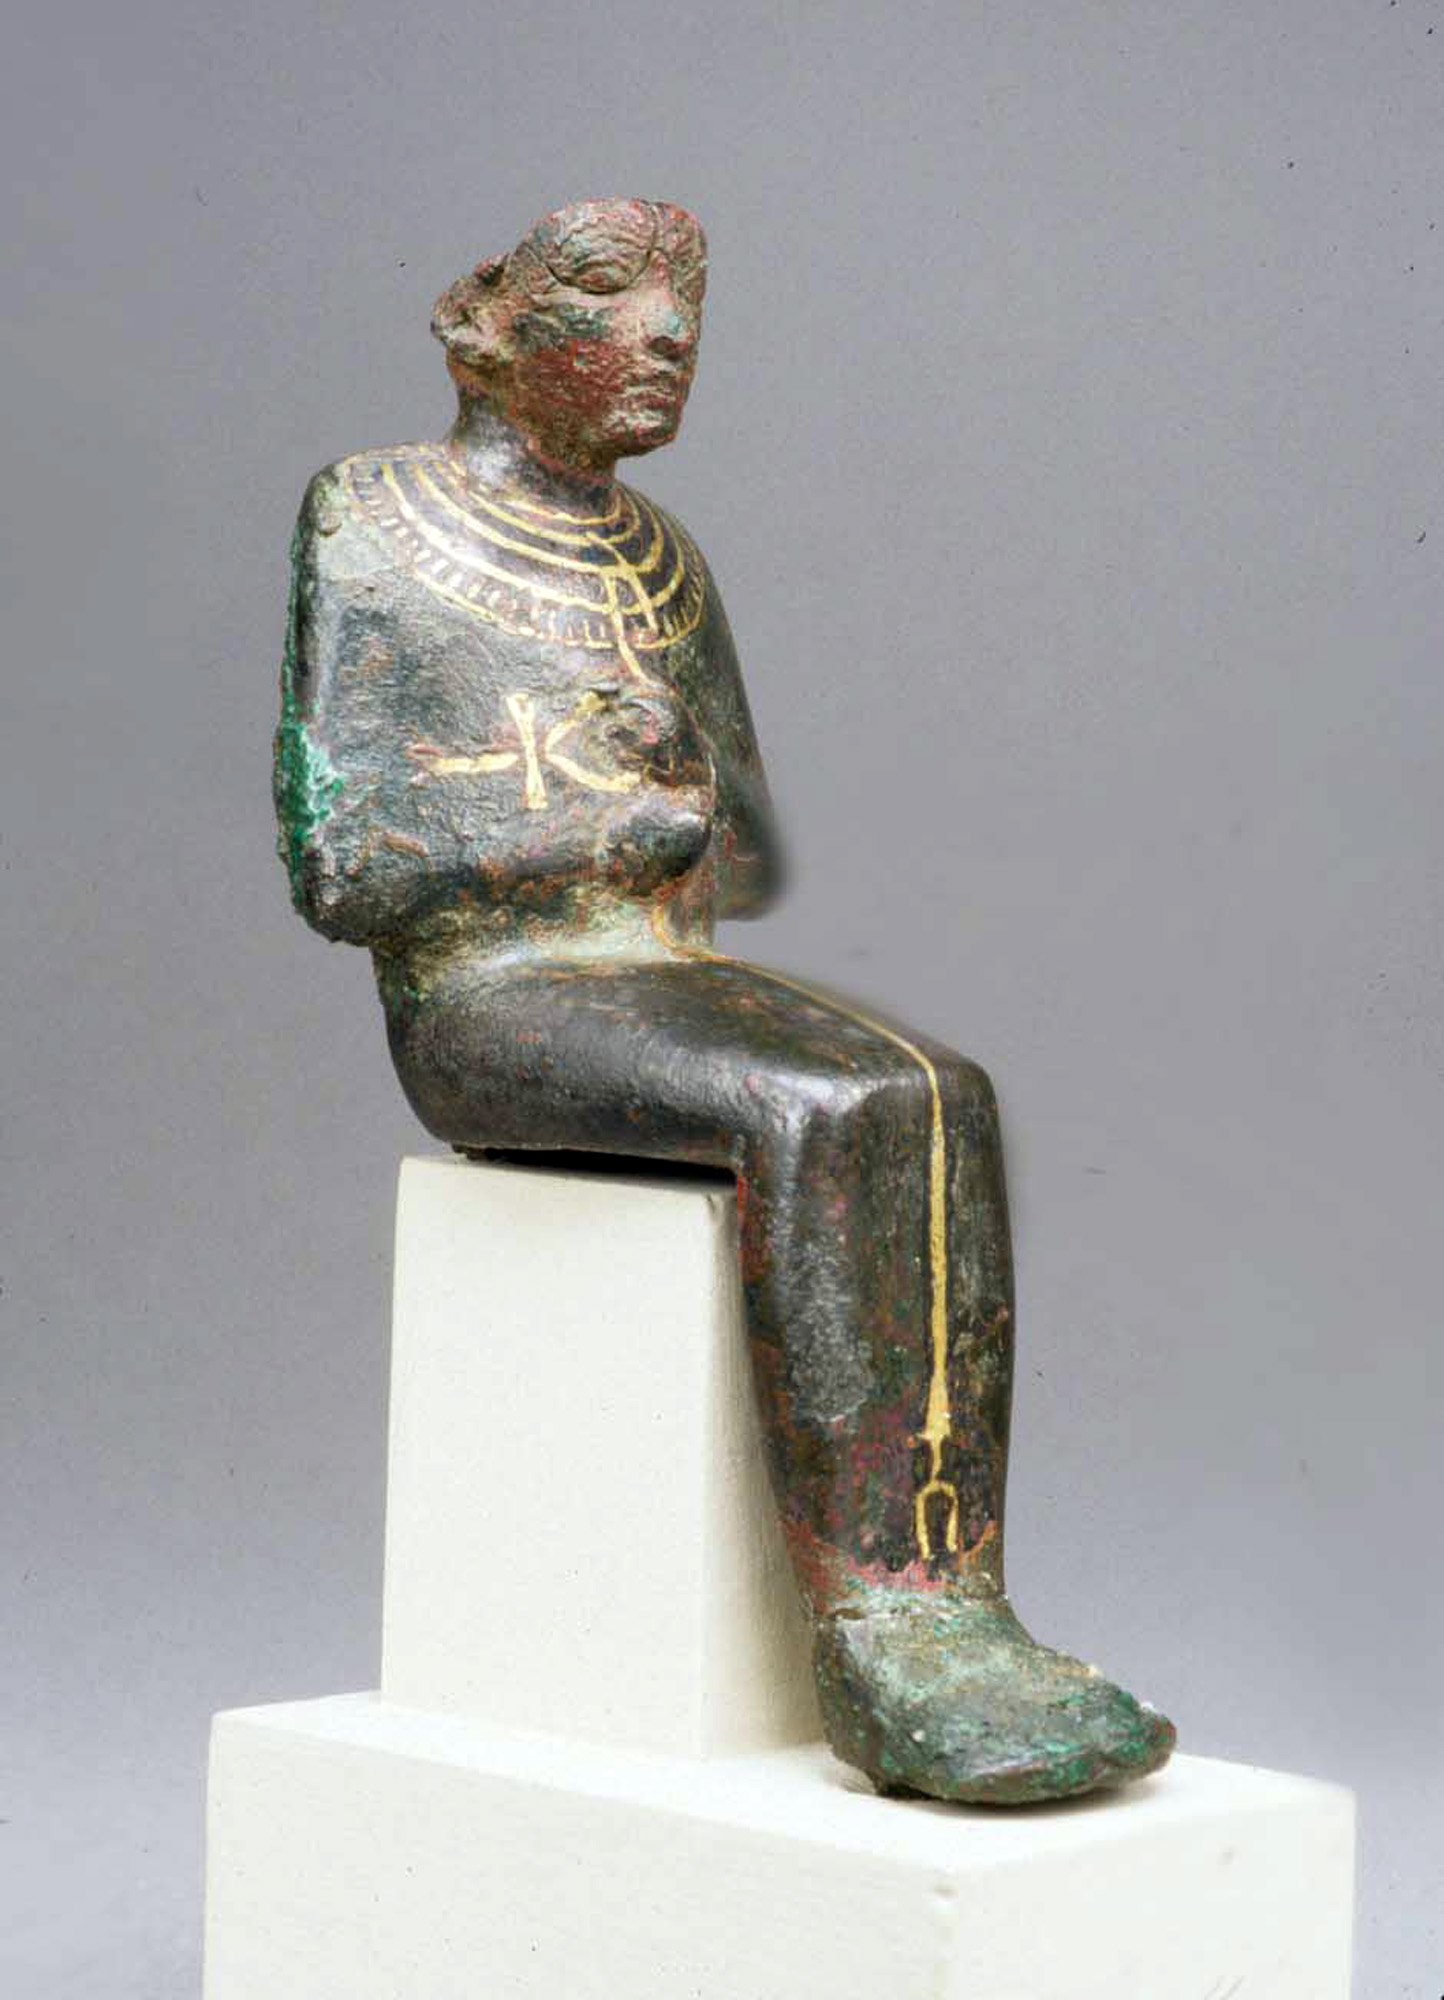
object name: statuette, ptah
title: Seated Ptah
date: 1070-664 BCE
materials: bronze, metal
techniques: inlay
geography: egypt